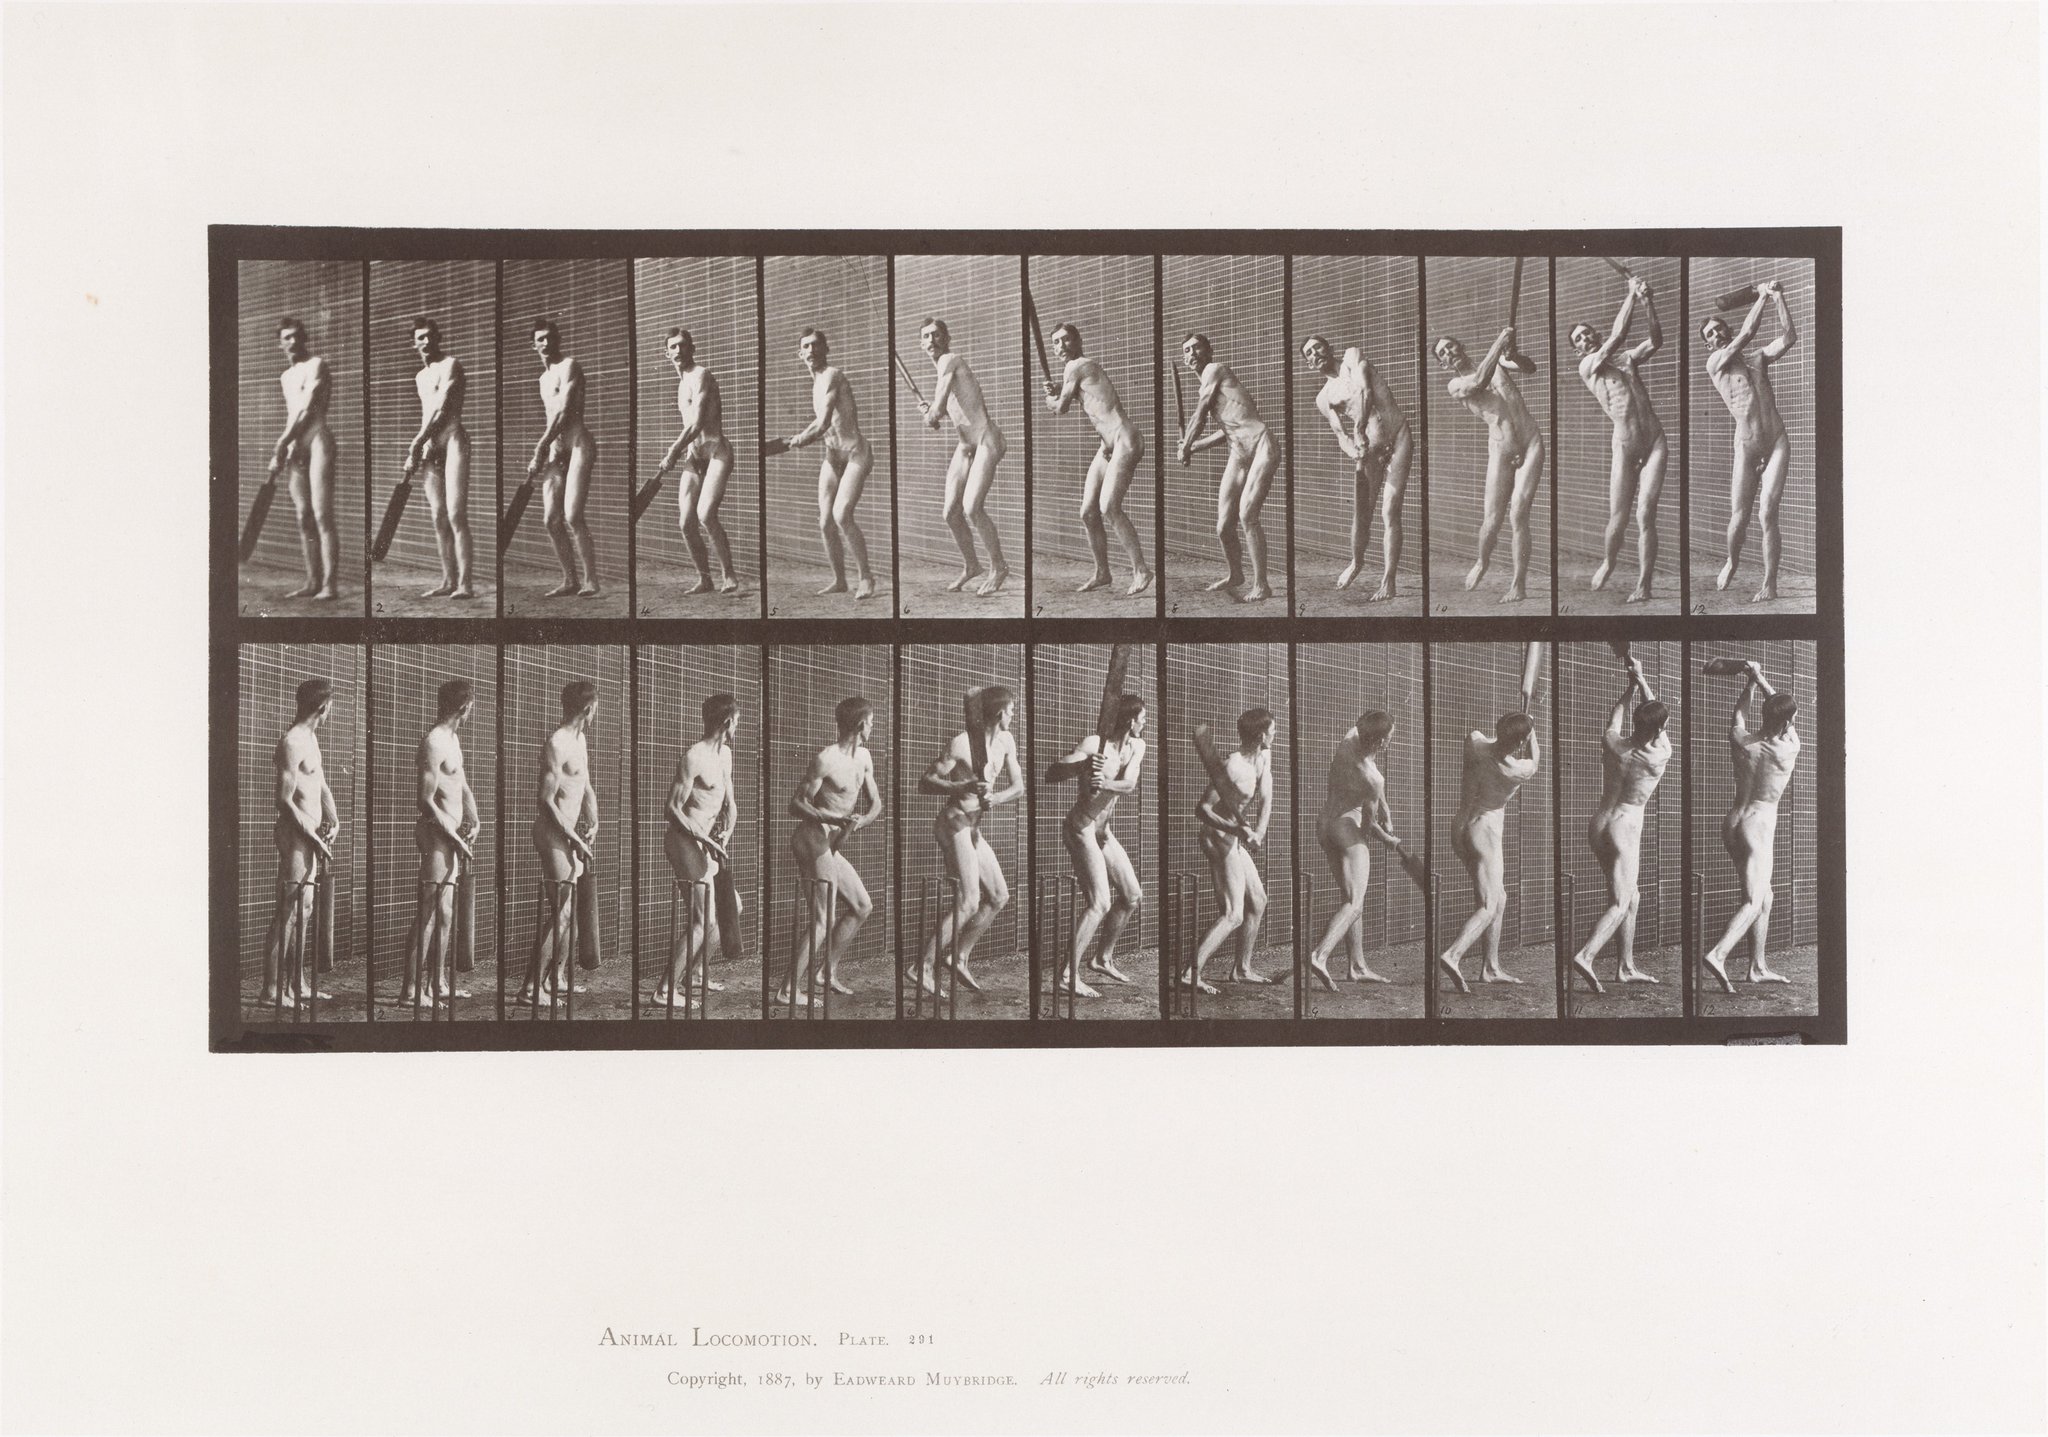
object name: photographically illustrated book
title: Animal Locomotion. An Electro-Photographic Investigation of Consecutive Phases of Animal Movements. Commenced 1872 - Completed 1885. Volume II, Men (Nude)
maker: eadweard muybridge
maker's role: artist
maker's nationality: british and american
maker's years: 1830-1904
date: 1880-1889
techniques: photogravure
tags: male nudes